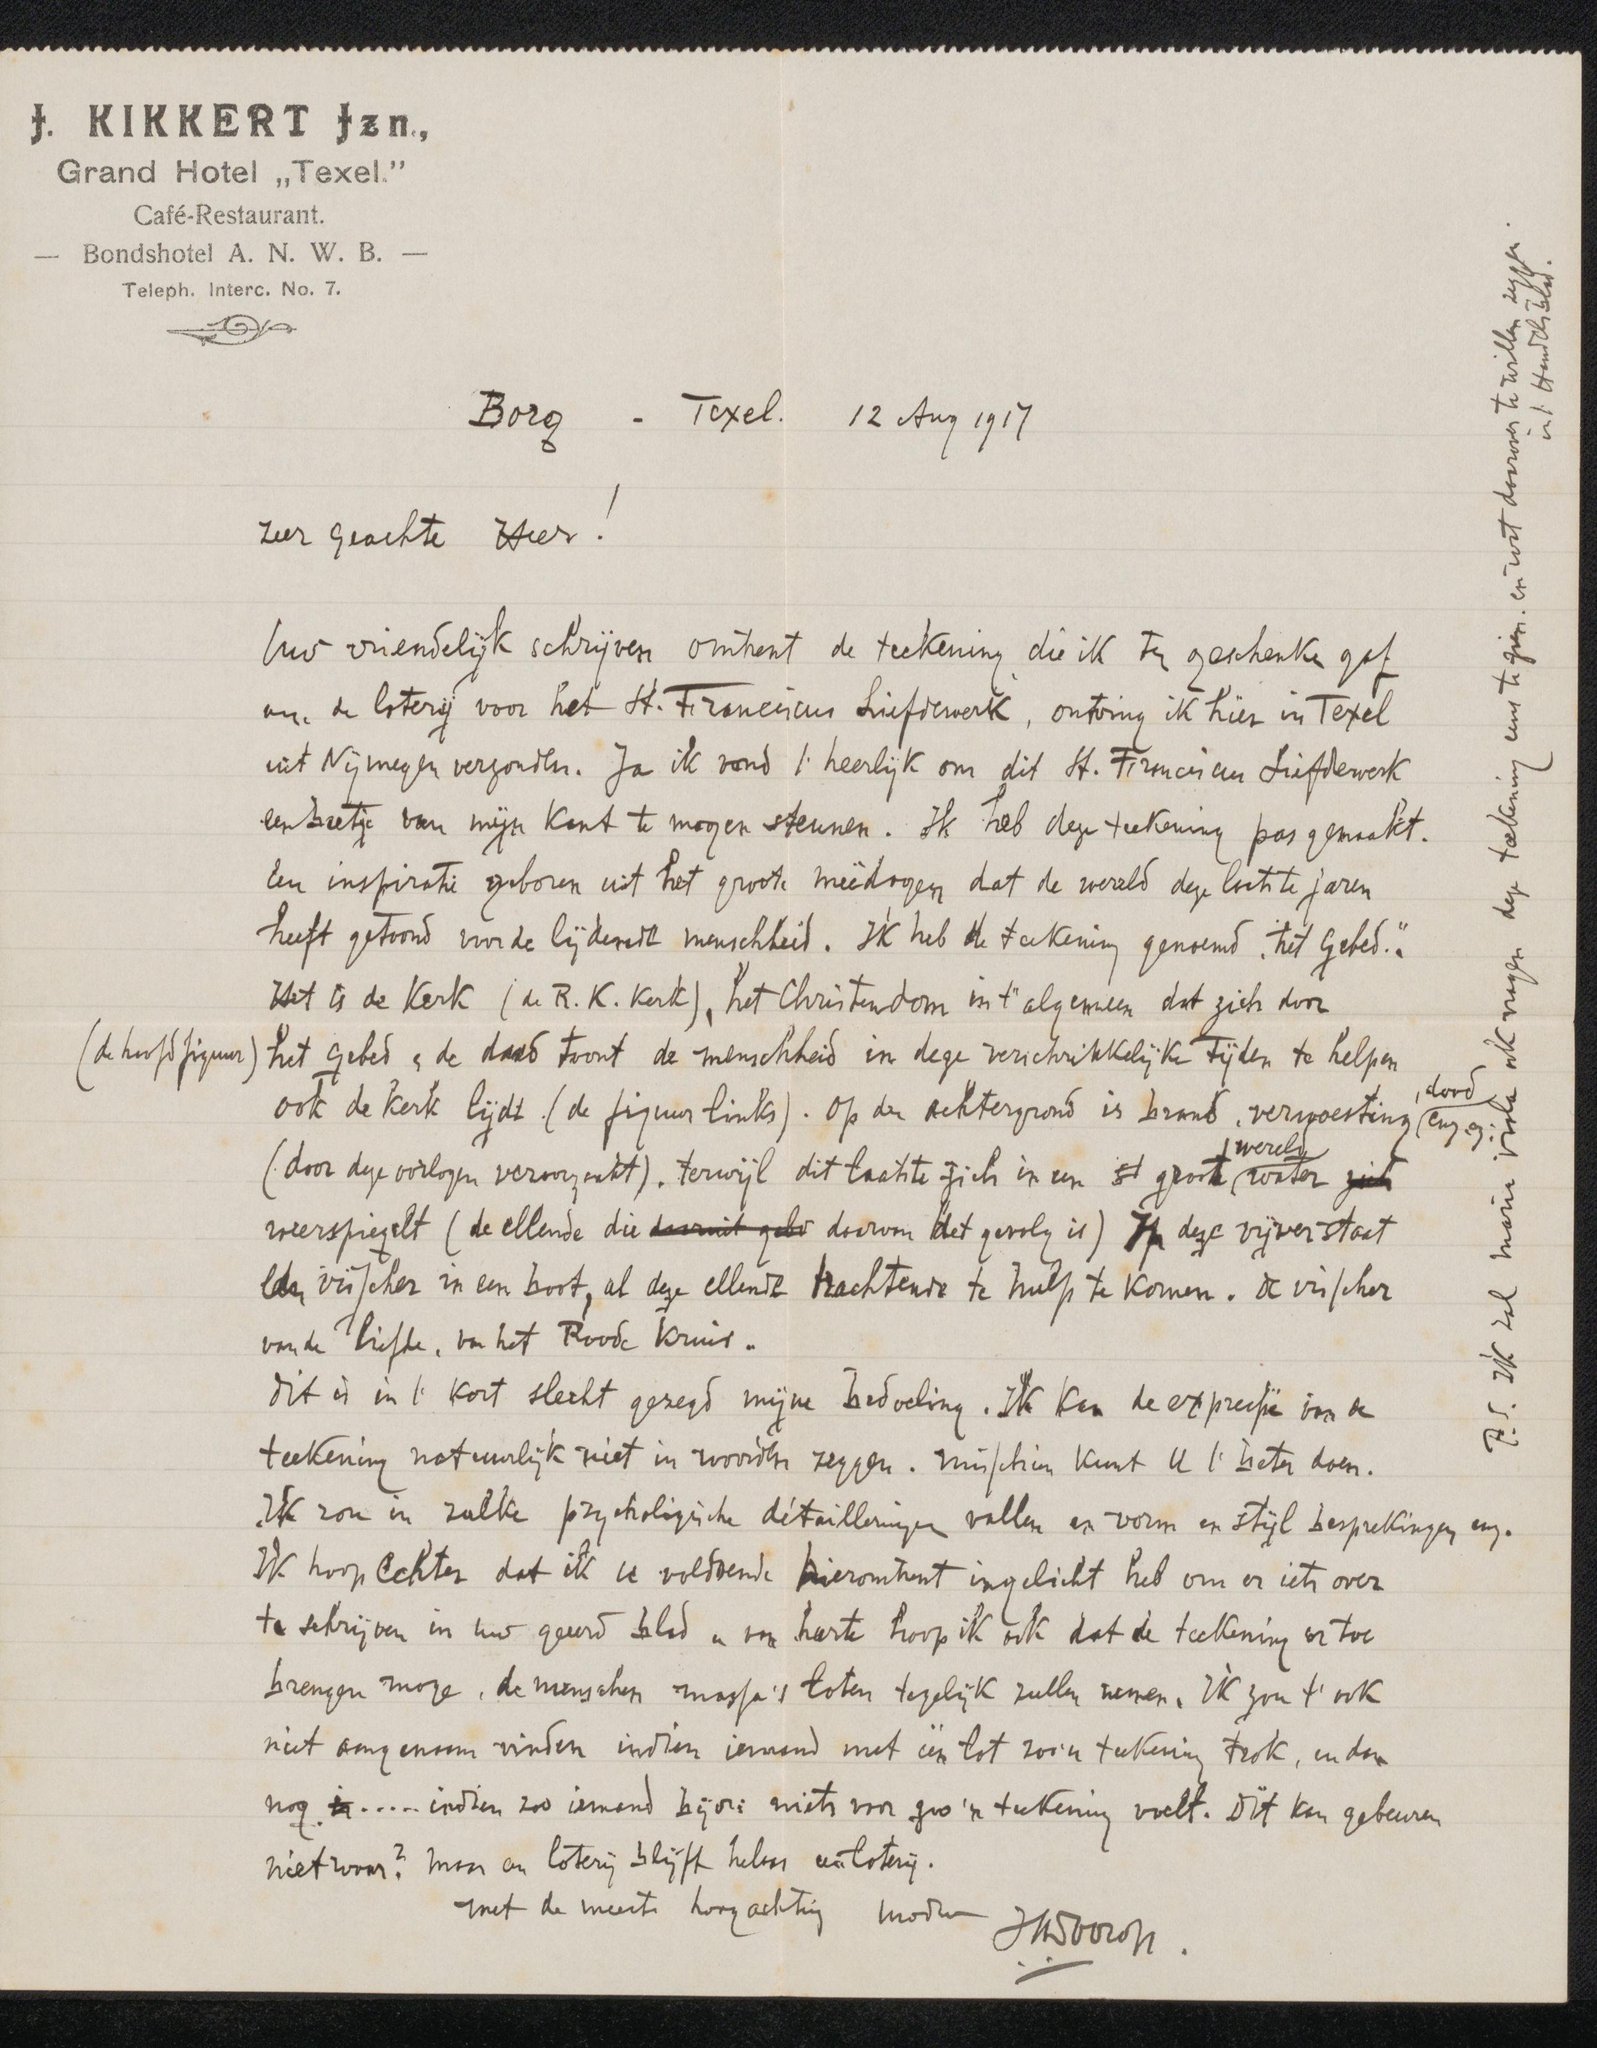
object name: letter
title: Brief aan L. van den Broeke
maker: jan toorop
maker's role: draughtsman, painter, print maker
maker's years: 1858-1928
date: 1917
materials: ink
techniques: pen, printing, writing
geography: texel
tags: criticizing and discussing art, art criticism, drawing, christian religion, charitable works